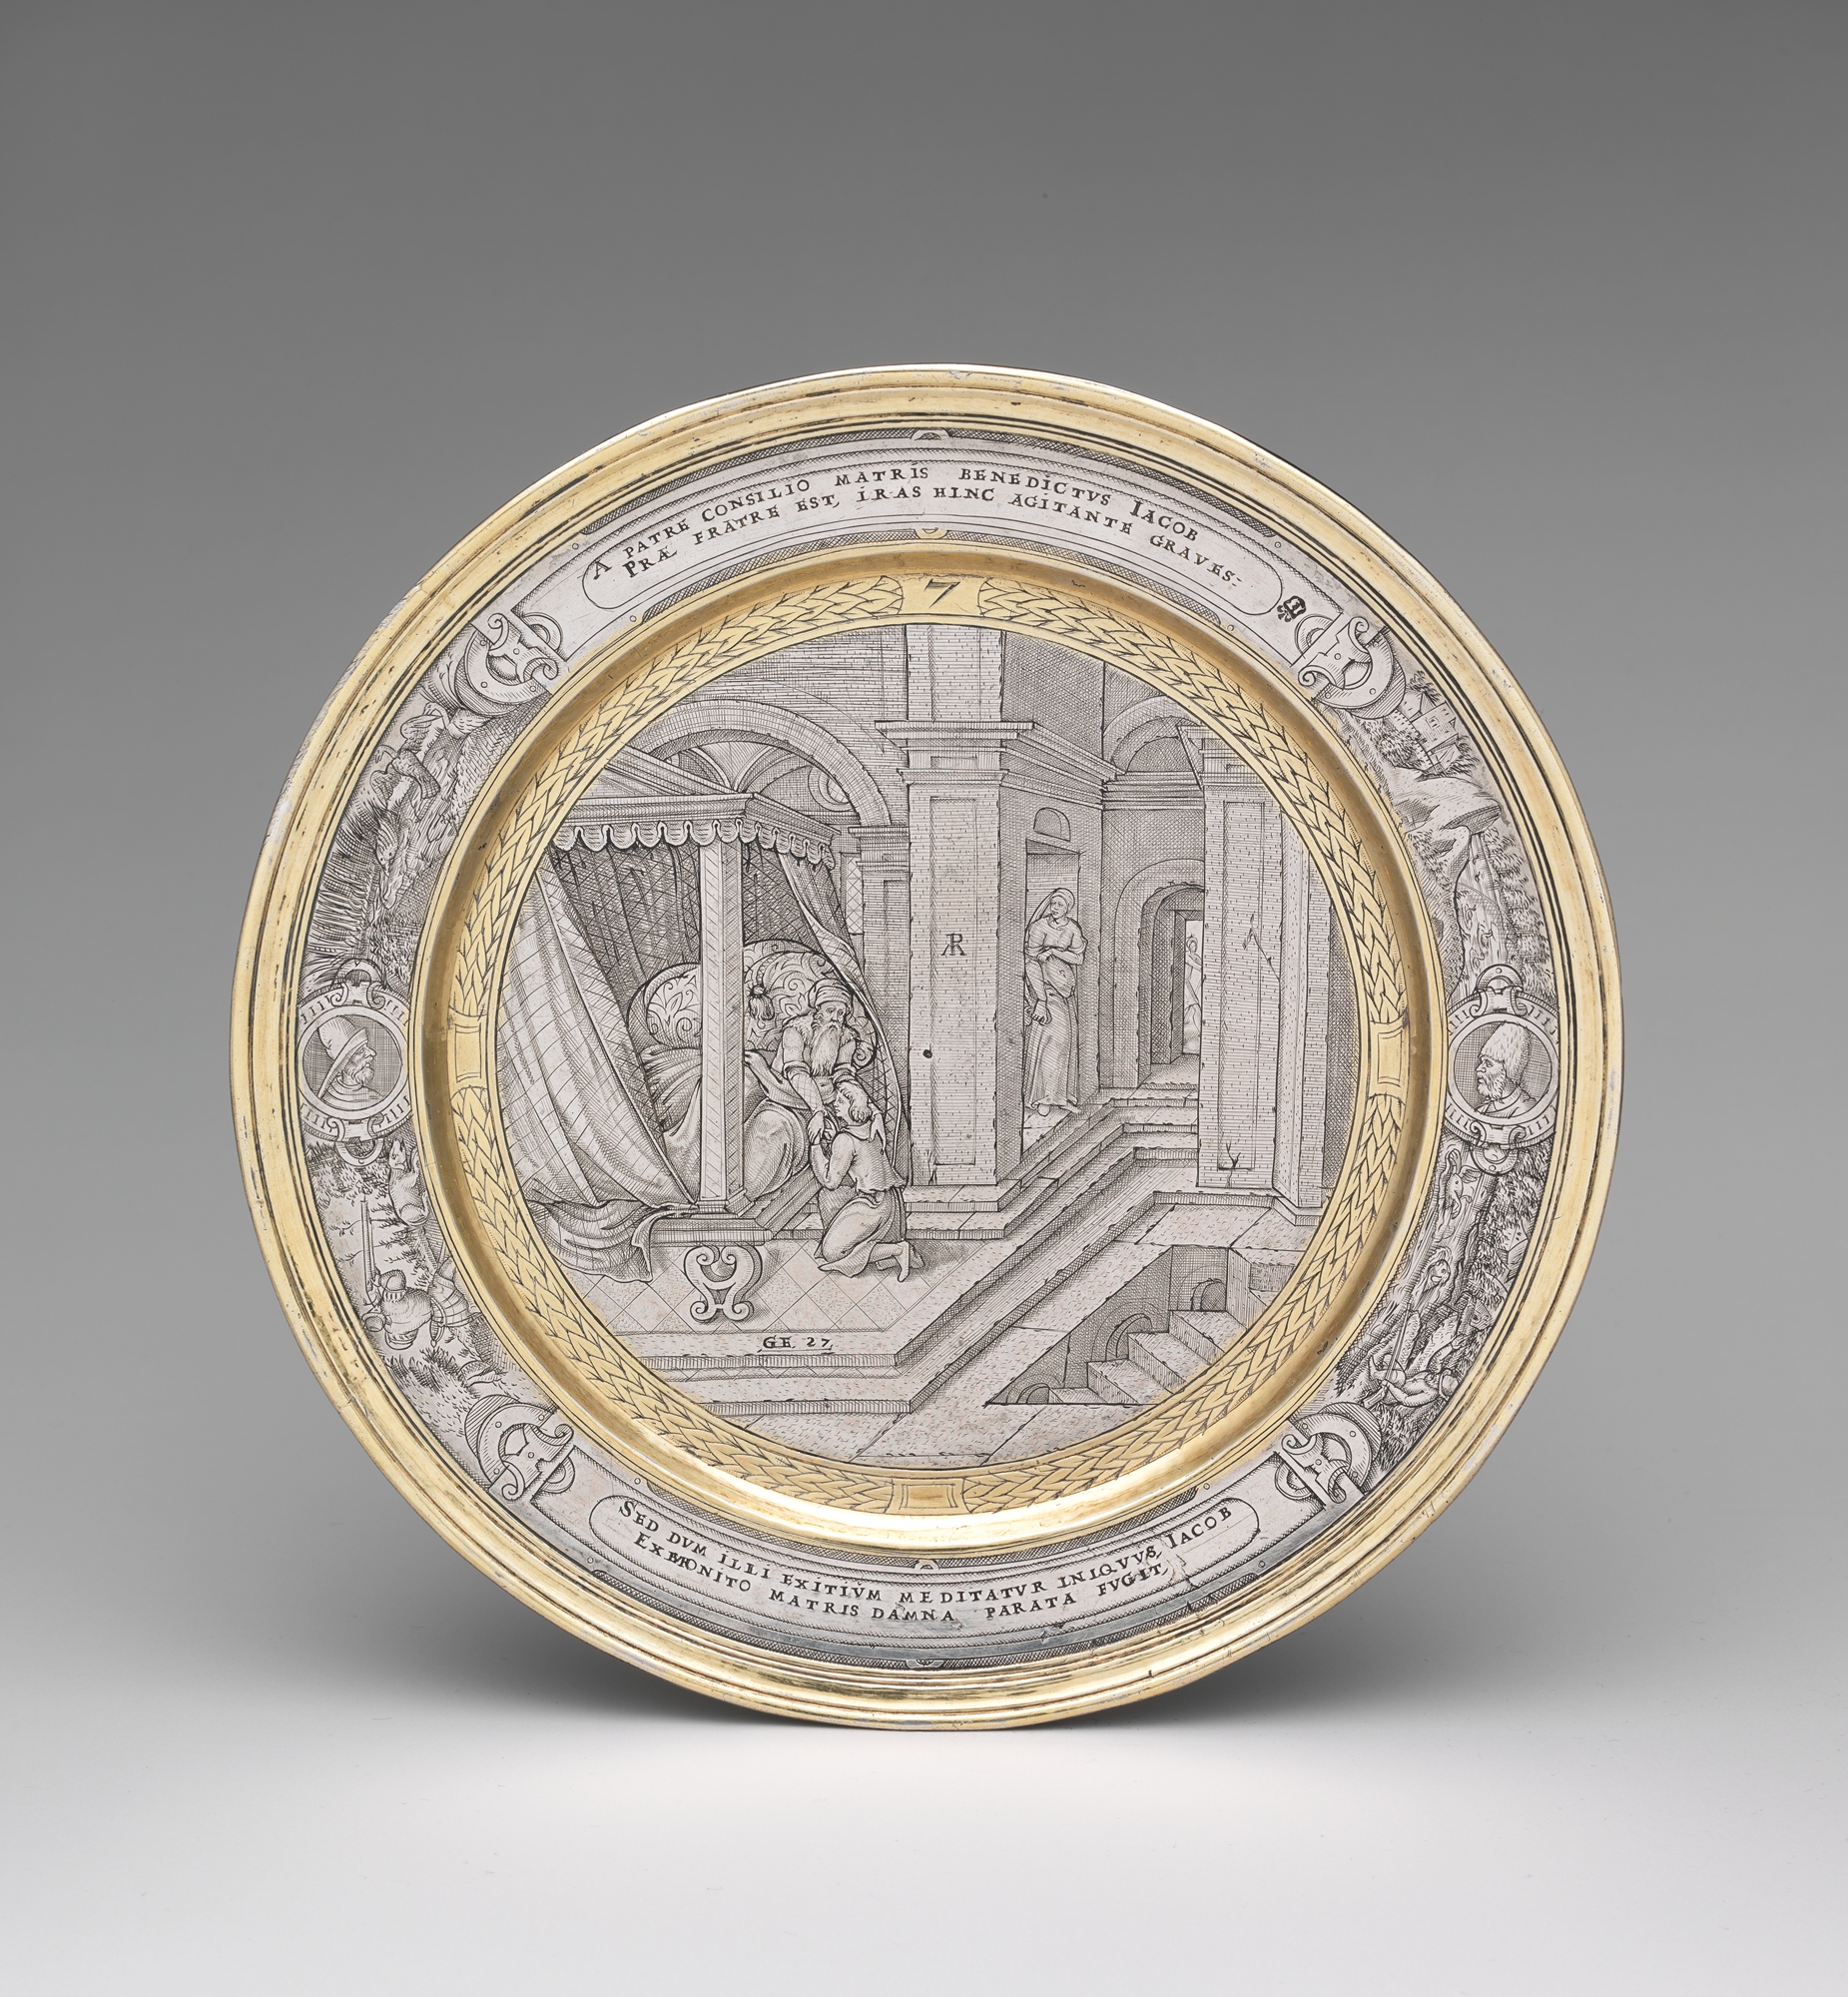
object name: plate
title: Jacob Blessed by Isaac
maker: p.m.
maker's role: engraver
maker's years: 1500-1600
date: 1567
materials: silver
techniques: gilding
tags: men